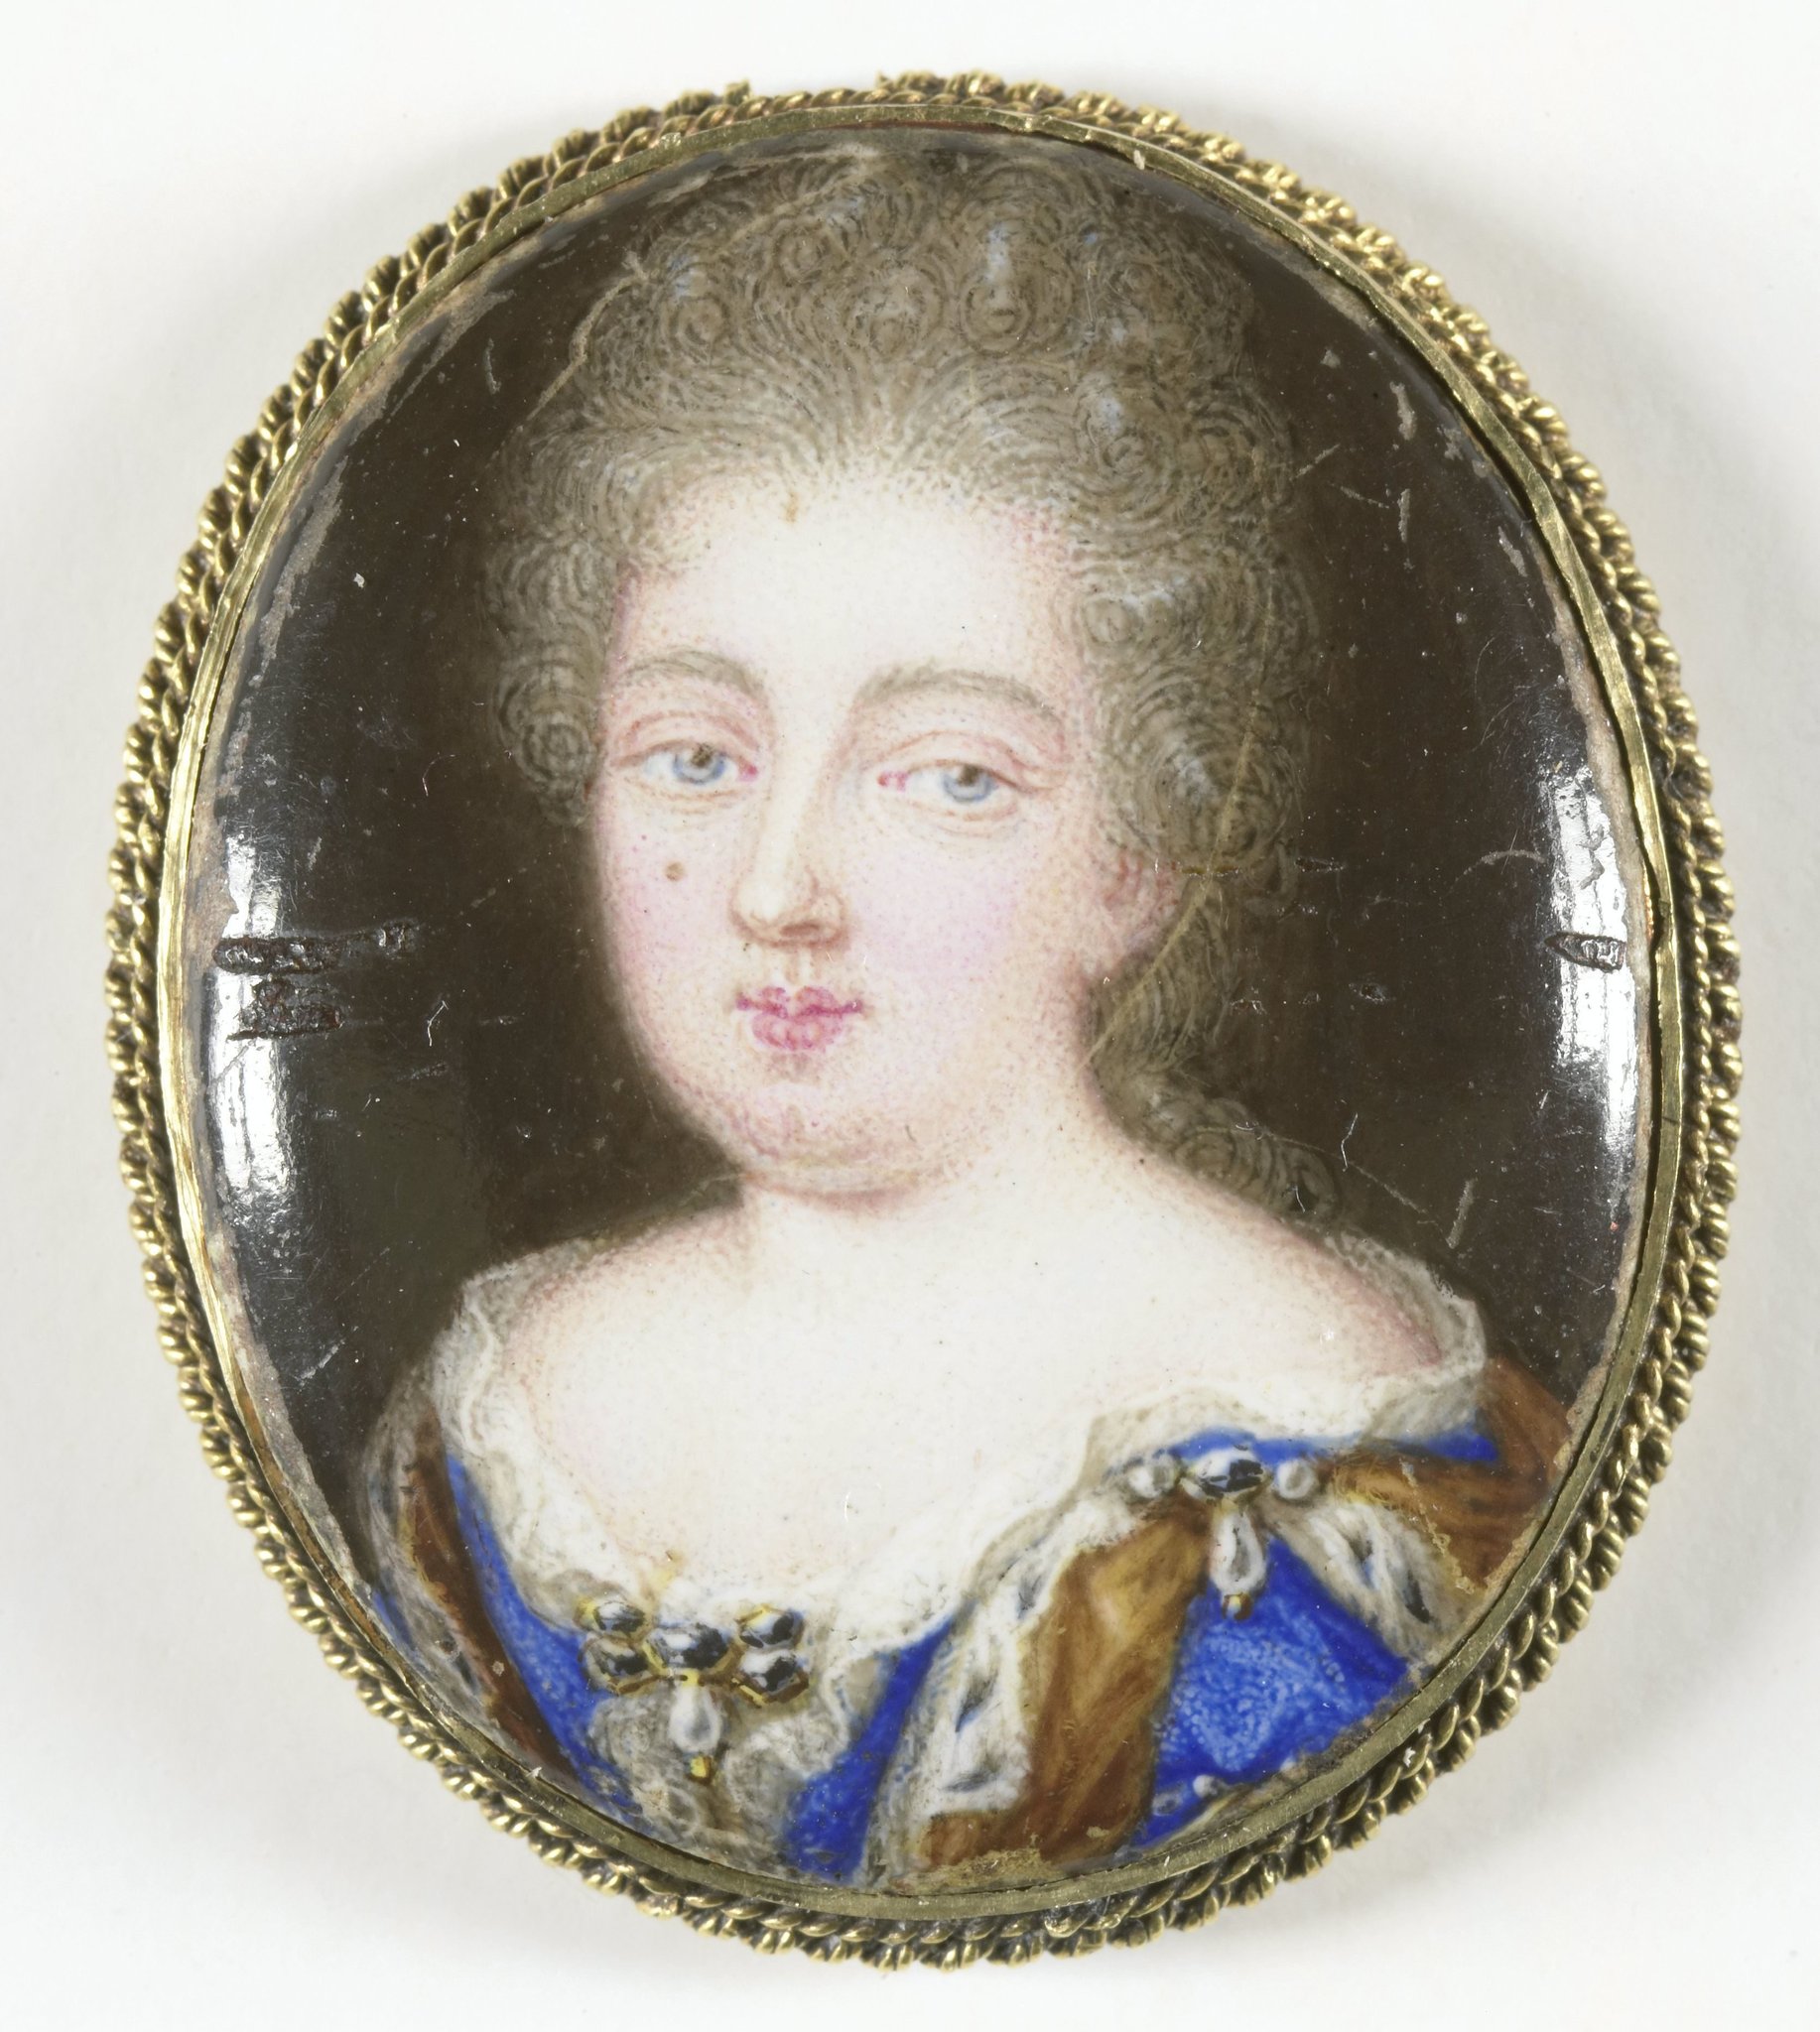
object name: painting, miniature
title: Portrait of an unidentified Woman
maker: pierre huaud (ii)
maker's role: miniatuurschilder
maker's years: 1647-1700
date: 1694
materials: copper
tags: historical persons not known by name - bb - woman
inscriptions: signature and date: ‘P. Huaut primo nata pinxit Berline 1694’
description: Portret van een onbekende vrouw, voorheen geïdentificeerd als vermoedelijk Anna Stuart (1665-1714), koningin van Engeland, echtgenote van George van Denemarken of als Sophie Charlotte van Hannover (1668-1705), vrouw van Frederik I van Pruisen. Buste, naar links. Onderdeel van de collectie portretminiaturen.